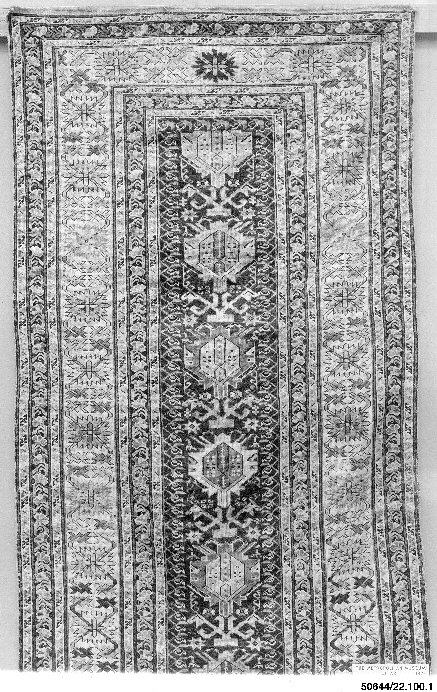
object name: carpet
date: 1801-1833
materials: wool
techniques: pile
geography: azerbaijan